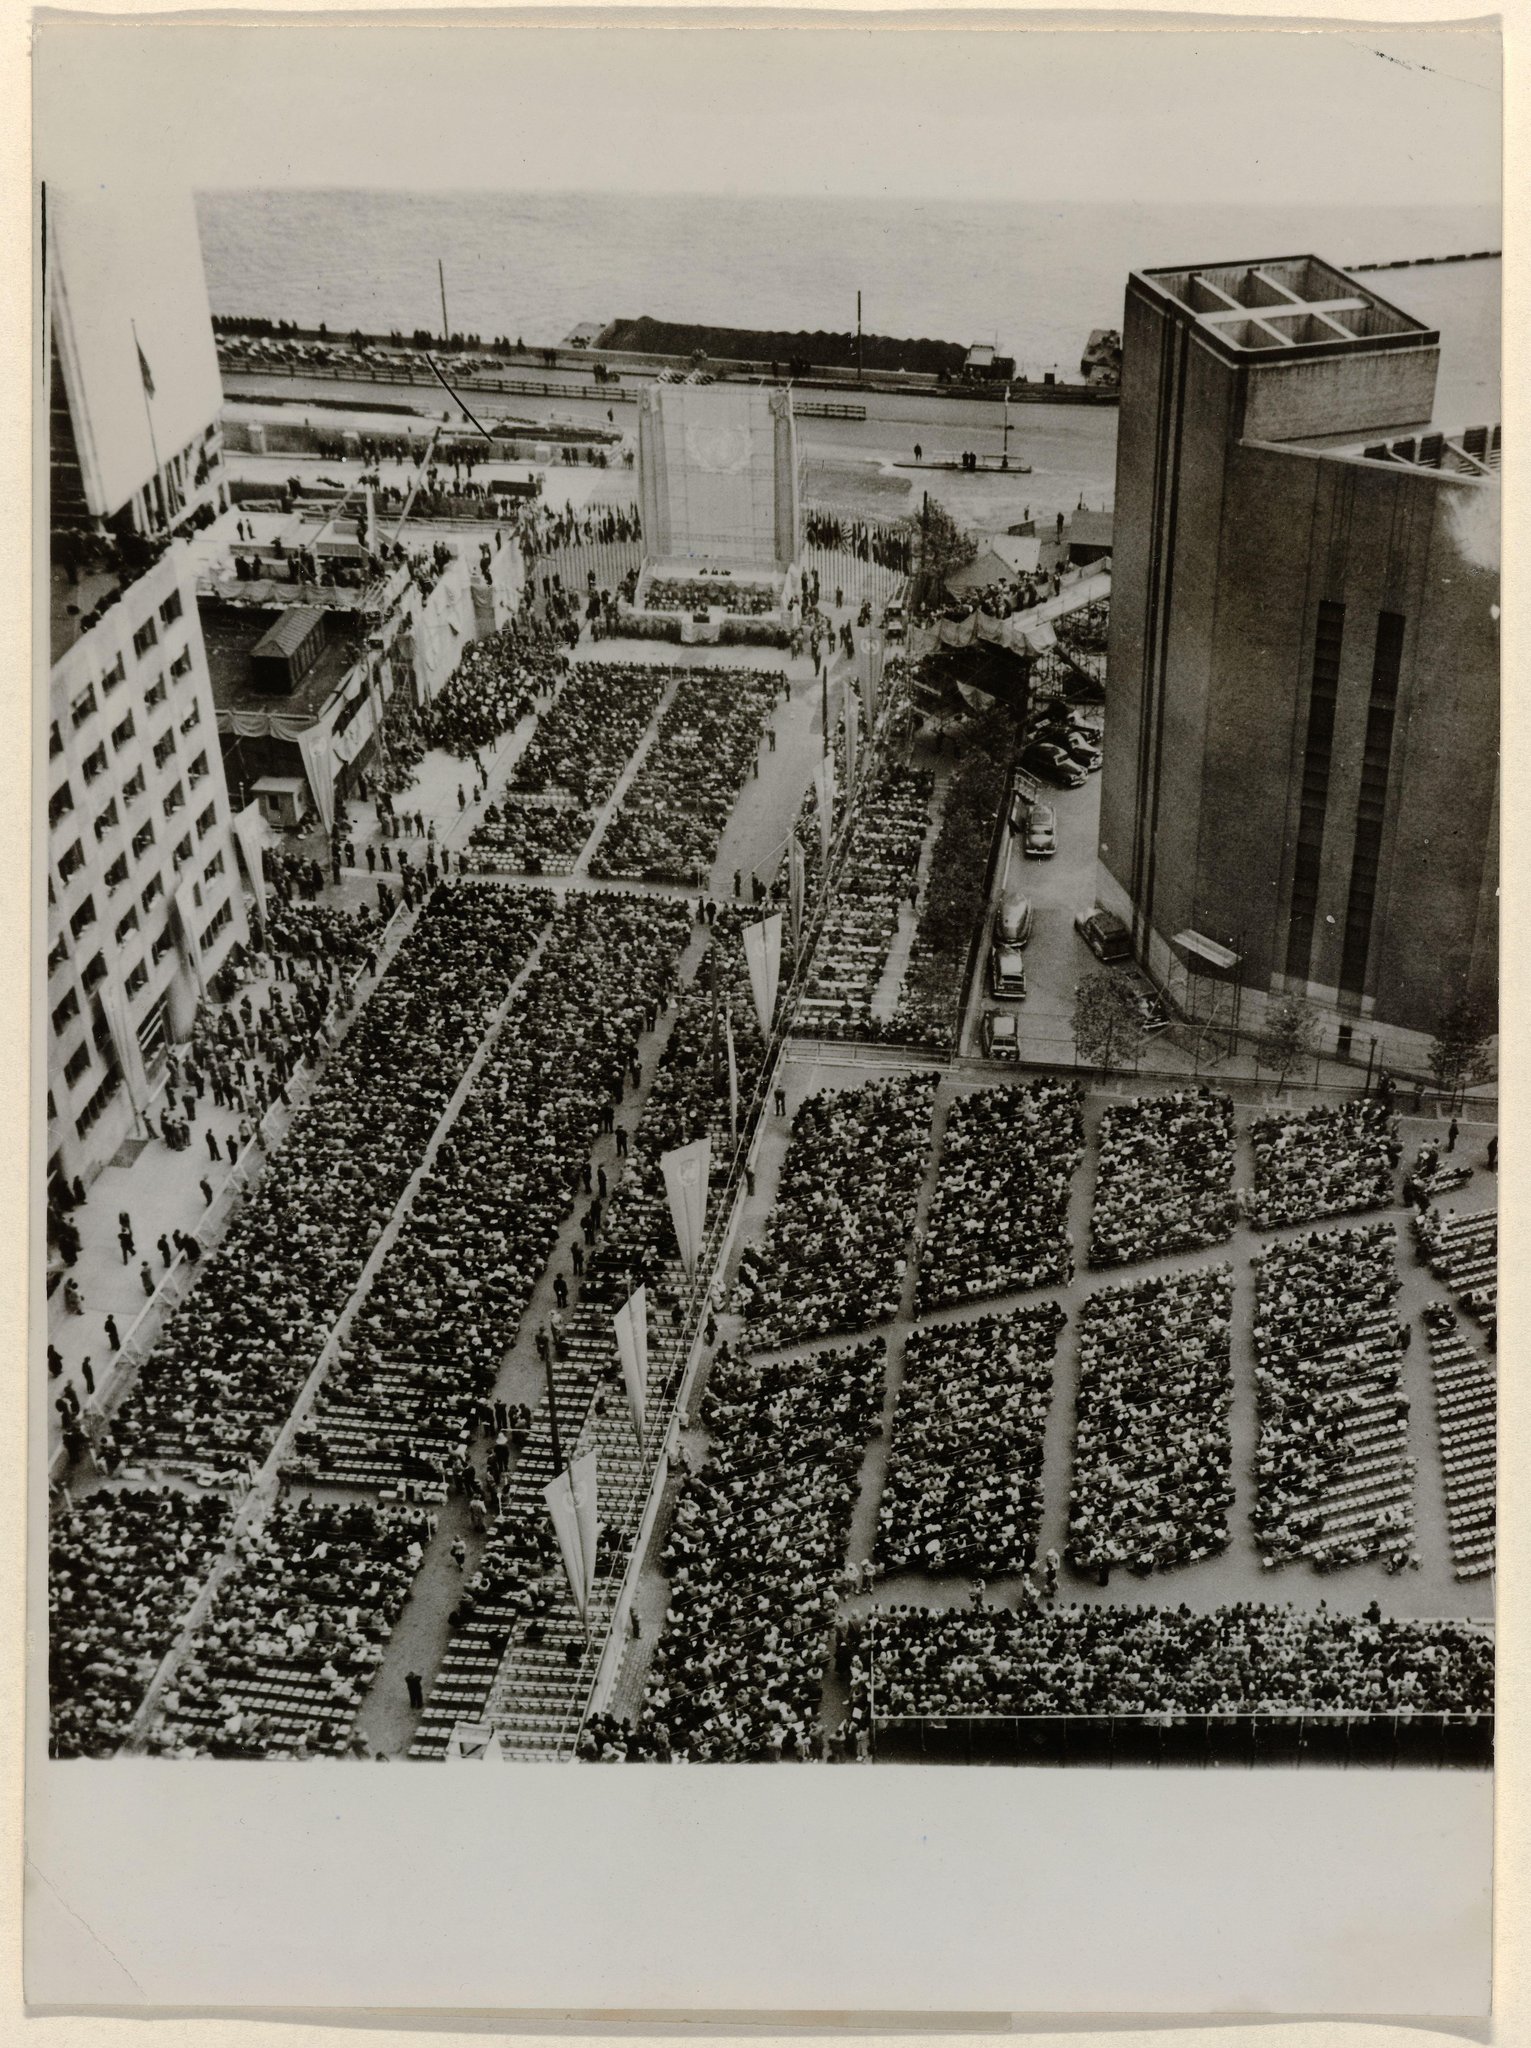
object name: photograph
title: United Nations corner-stone laid at organisation's permanent headquarters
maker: Anonymous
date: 1949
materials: paper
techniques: gelatin silver print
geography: london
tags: address, talk, lecture (~ meeting) - aa - in the open air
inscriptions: inscription: ‘KEYSTONE/ 219 EAST 4th STREET,/ NEW YORK/ N.Y./ RED LION COURT,/ FLEET STREET,/ LONDON/ E.C.4.’, copyright notice: ‘COPYRIGHT/ PHOTO PRESS BELGIUM S.A./ 108, Avenue de France, Anvers - Tél. 237.71/ 23, rue des Sables, Bruxelles - Tél. 18.33.27/ C. Ch. Postaux 96.49 - R.C.A. 166.717’, inscription: ‘About 10,000 people, including delegates to the/ United Nations, attended the dedication of the/ World organisation's permanent headquarters in the/ centre of New York. The corner-stone of the new/ building was laid by M. Lie, the Secretary-General/ and Mr. Truman was the principal speaker at the/ ceremony./ PHOTO SHOWS/ A view of the ceremony during the/ laying of the corner-stone./ 1/J. Keystone. 1/552786.’